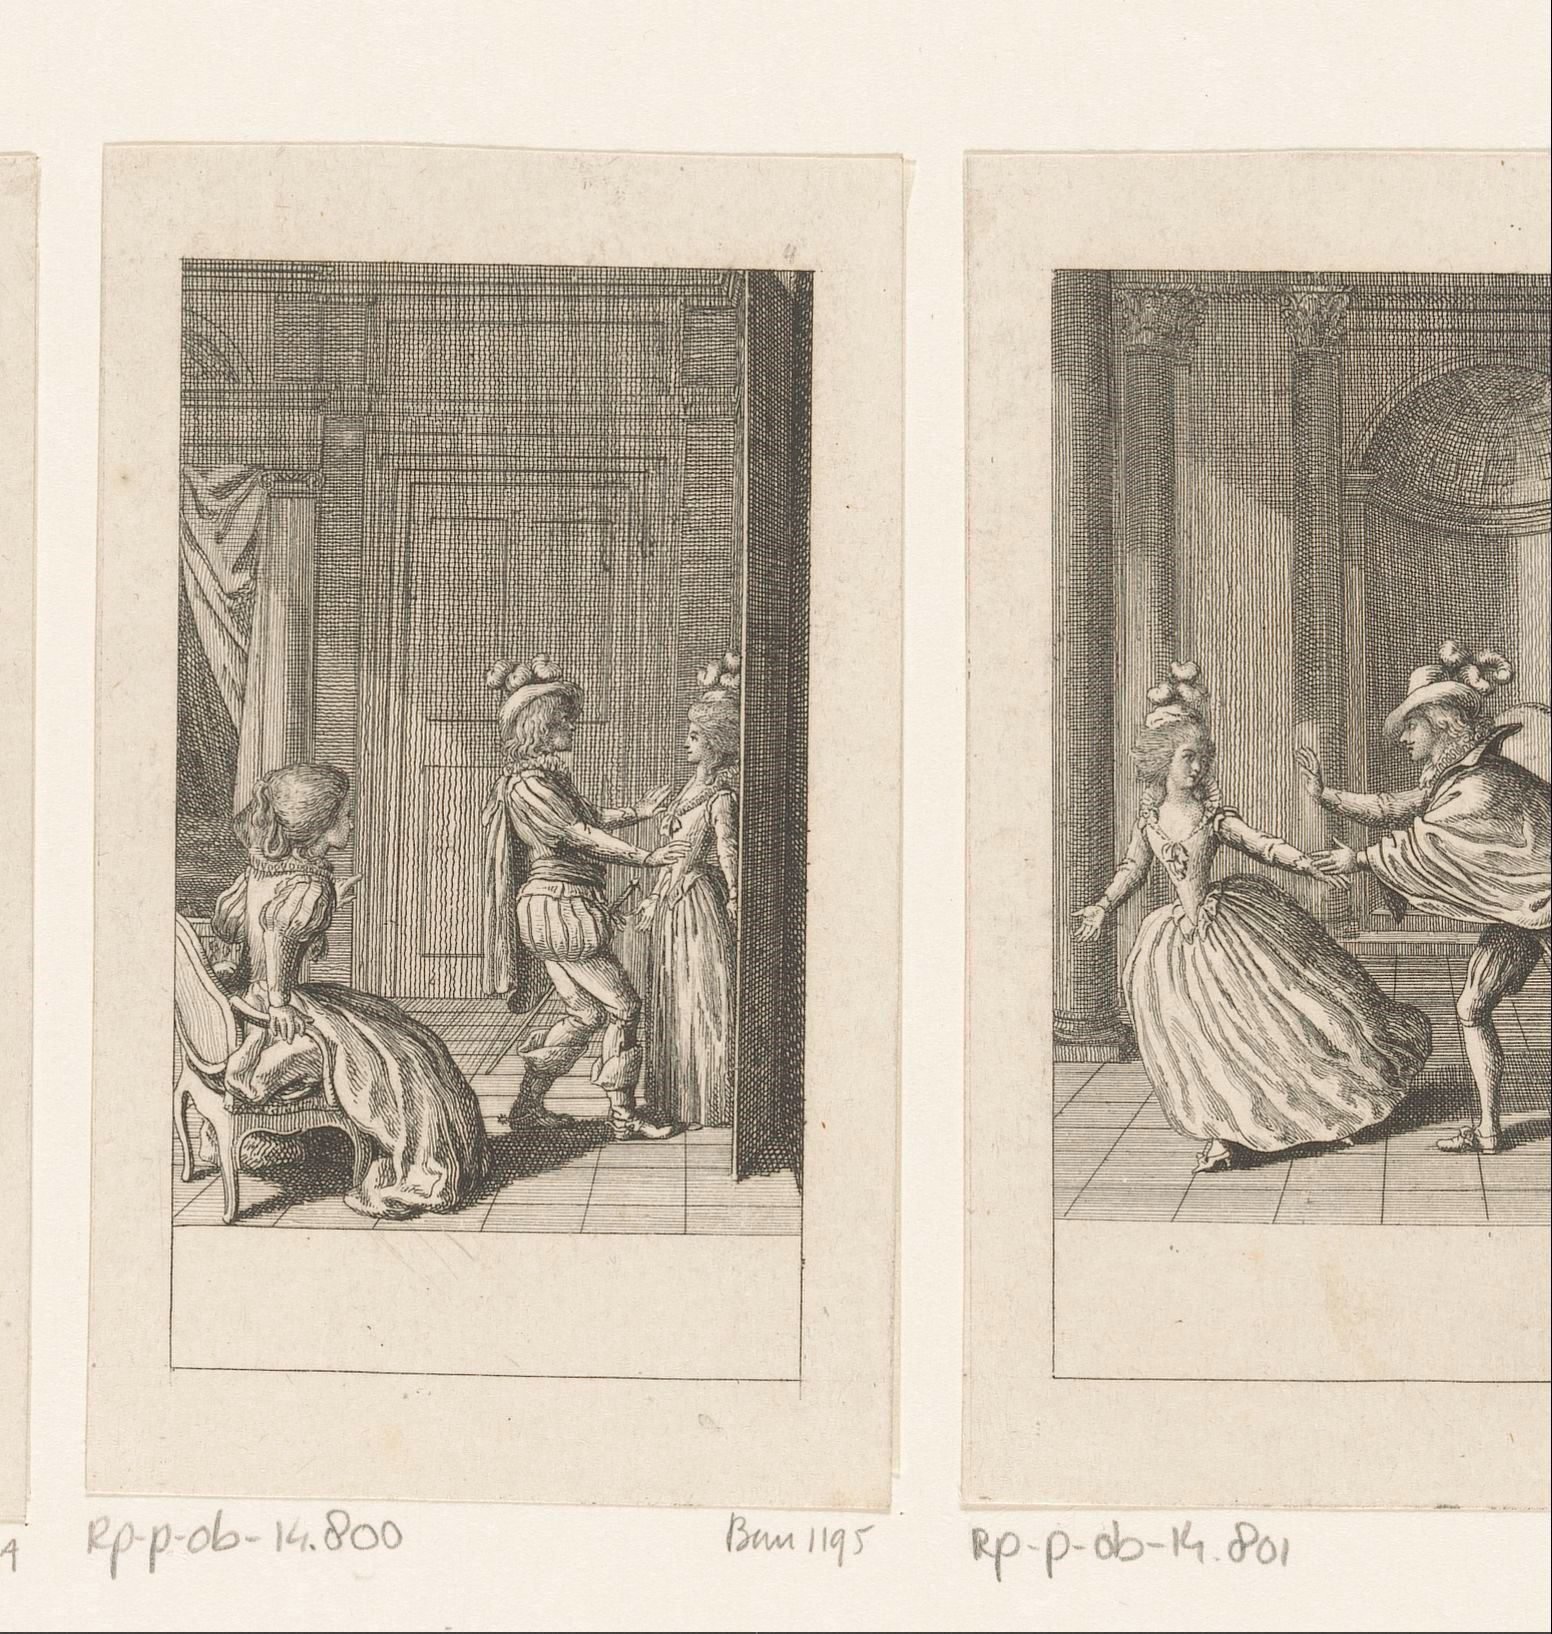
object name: print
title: Suzanne en Chérubim komen lachend binnen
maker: daniel nikolaus chodowiecki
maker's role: draughtsman, print maker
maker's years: 1726-1801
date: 1785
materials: paper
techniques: etching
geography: berlin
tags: publisher, literature, cheat, deceit; 'fraude', 'inganno' (ripa)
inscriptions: collector's mark: Lugt 2228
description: Vervaardigd voor 'le Mariage de Figaro' van Pierre Augustin Caron de Beaumarchais. Latere staat gebruikt voor: Almanac de Gotha contenant diverses connoissances curieuses et utiles pour l'année (...). Gotha: C. W. Ettinger, 1785.